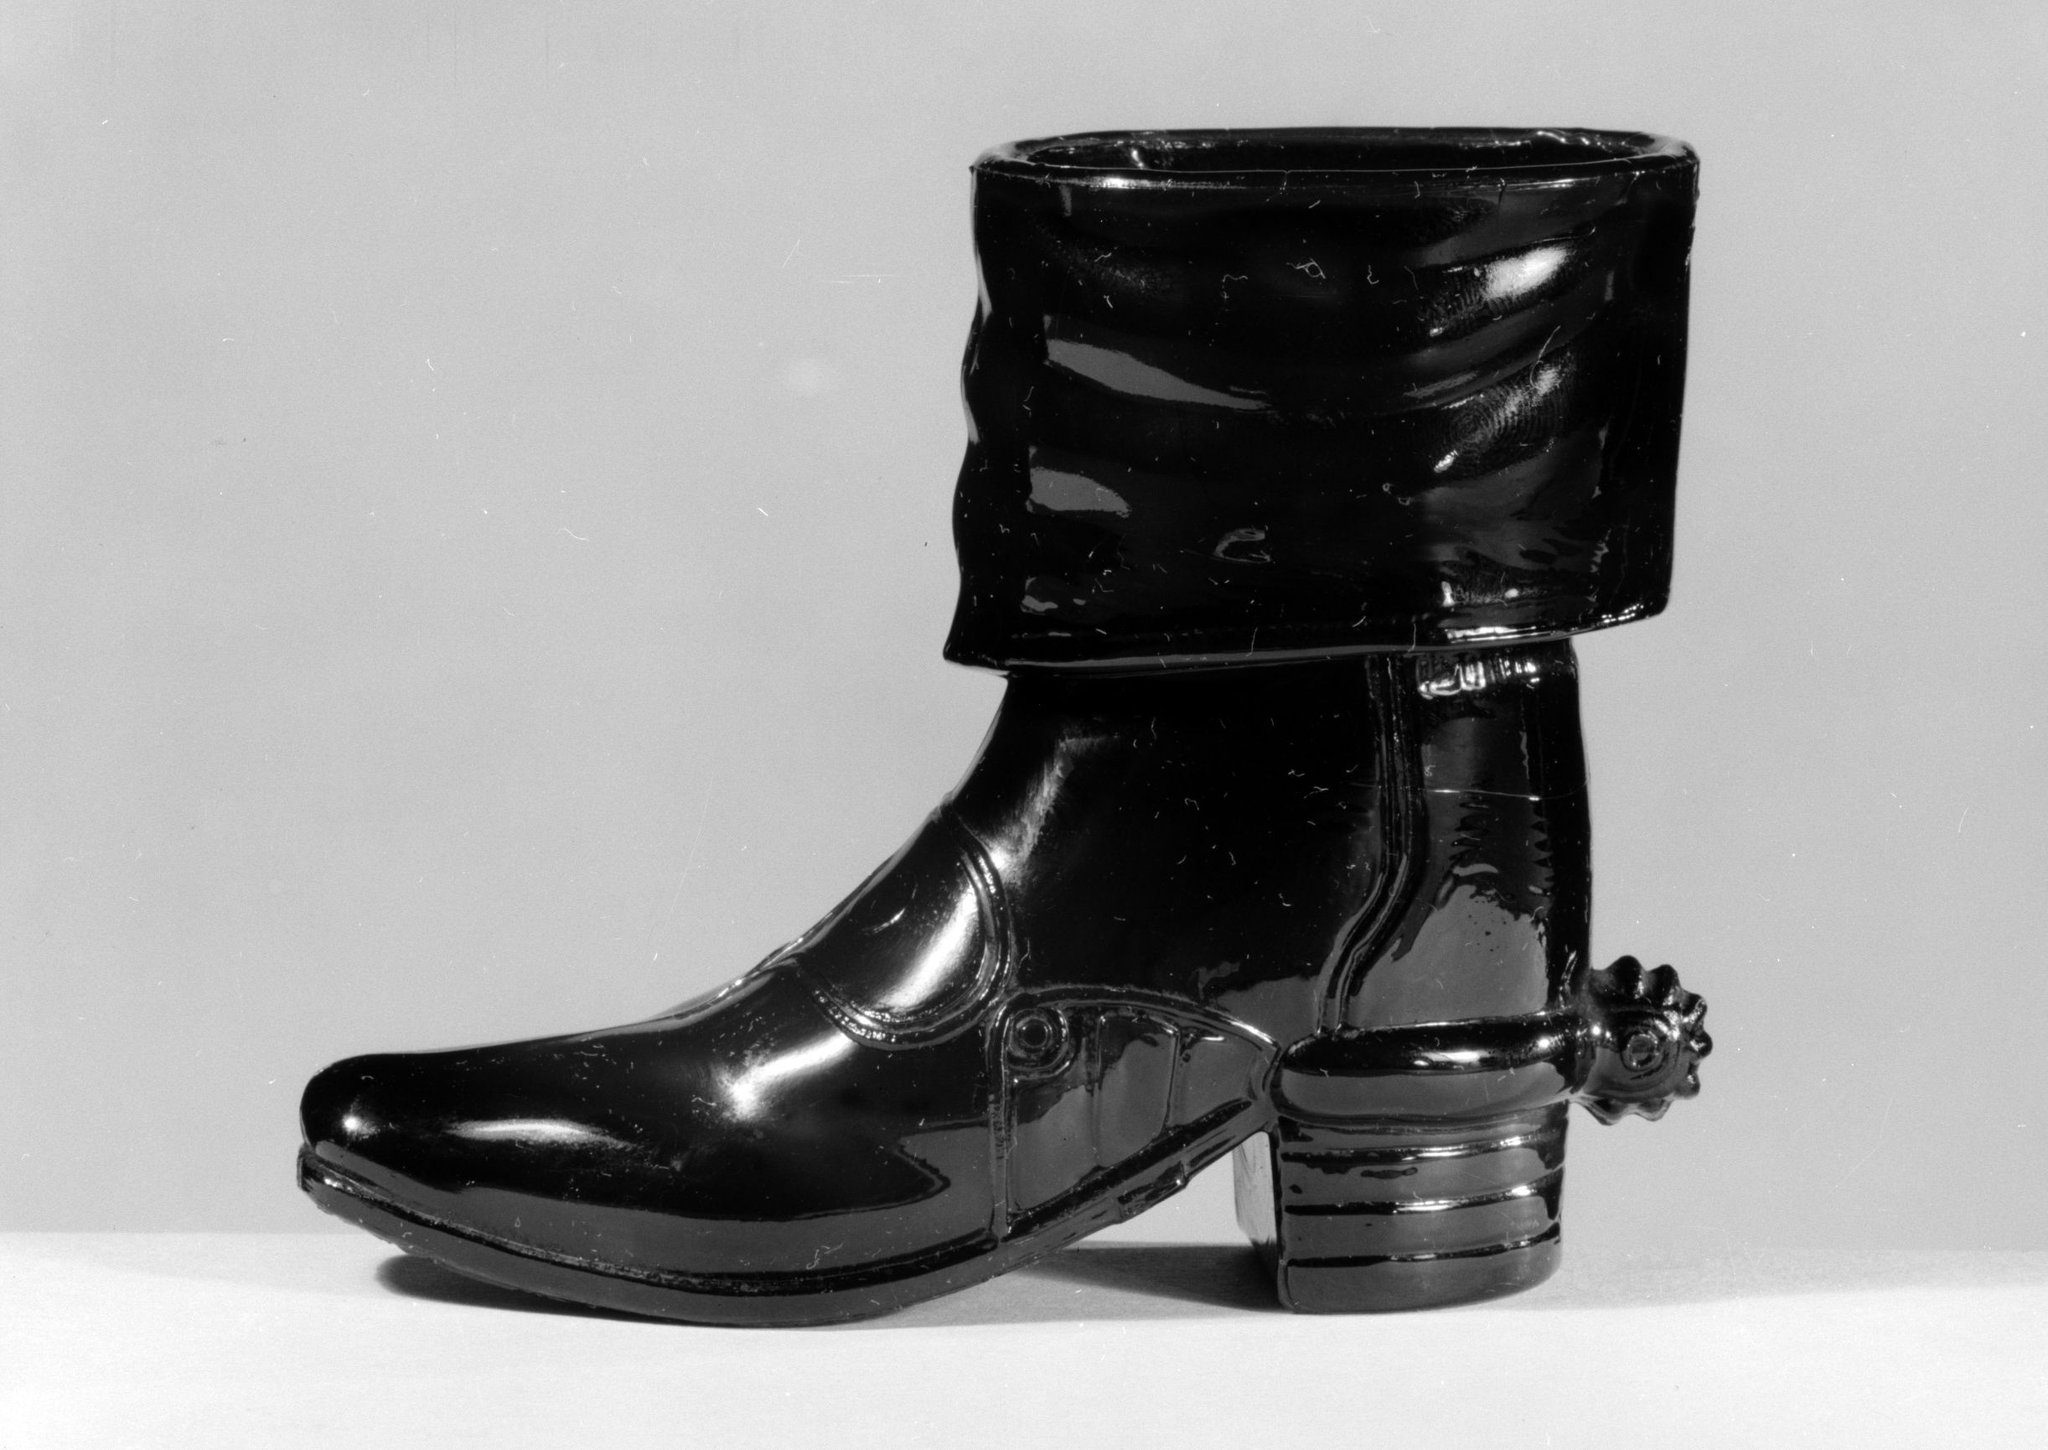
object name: sculpture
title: Boot with Spur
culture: american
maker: challinor, taylor and company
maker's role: maker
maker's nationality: american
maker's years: 1866-1891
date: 1870-1890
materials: glass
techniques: pressed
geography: united states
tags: boots